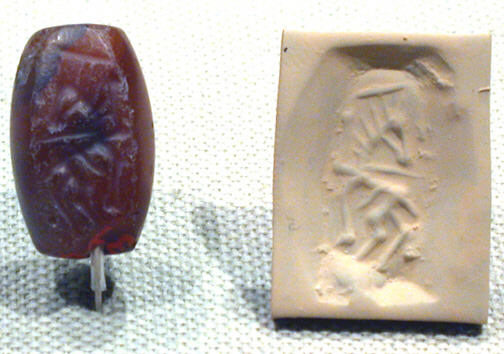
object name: stamp seal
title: Stamp seal (loaf-shaped hemispheroid) with animal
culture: southwest arabian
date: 700-501 BCE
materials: gemstone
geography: southwestern arabia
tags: horses